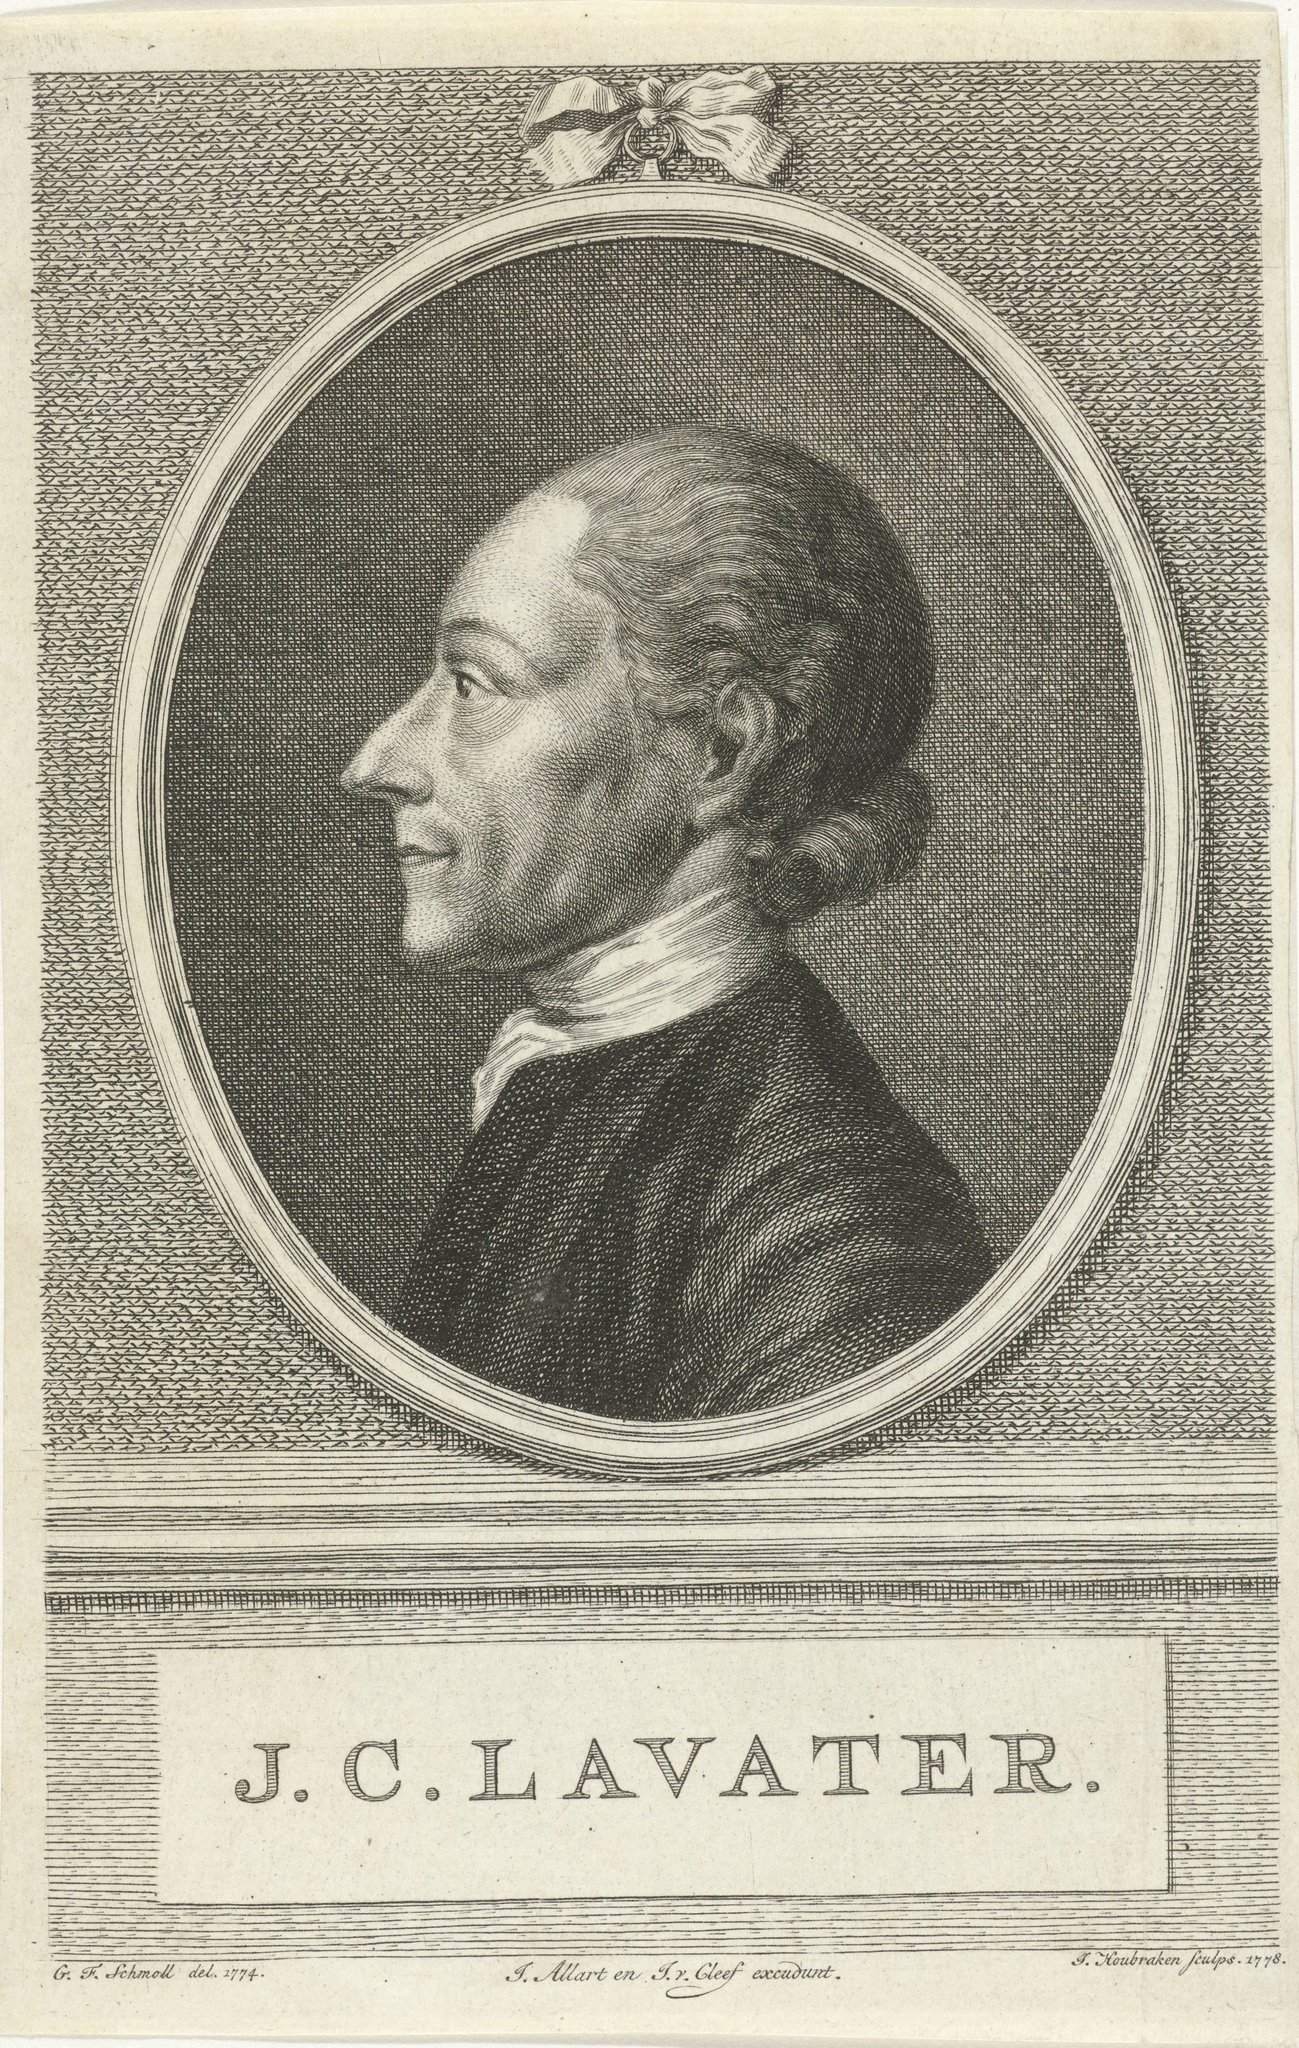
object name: print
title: J.C. Lavater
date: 1778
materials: paper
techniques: engraving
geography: the hague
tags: johann caspar lavater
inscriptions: collector's mark: Lugt 2228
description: Buste naar links van Johann Kaspar Lavater in een ovaal medaillon met bovenaan een strik. Onder het portret een richel waarop zijn naam.